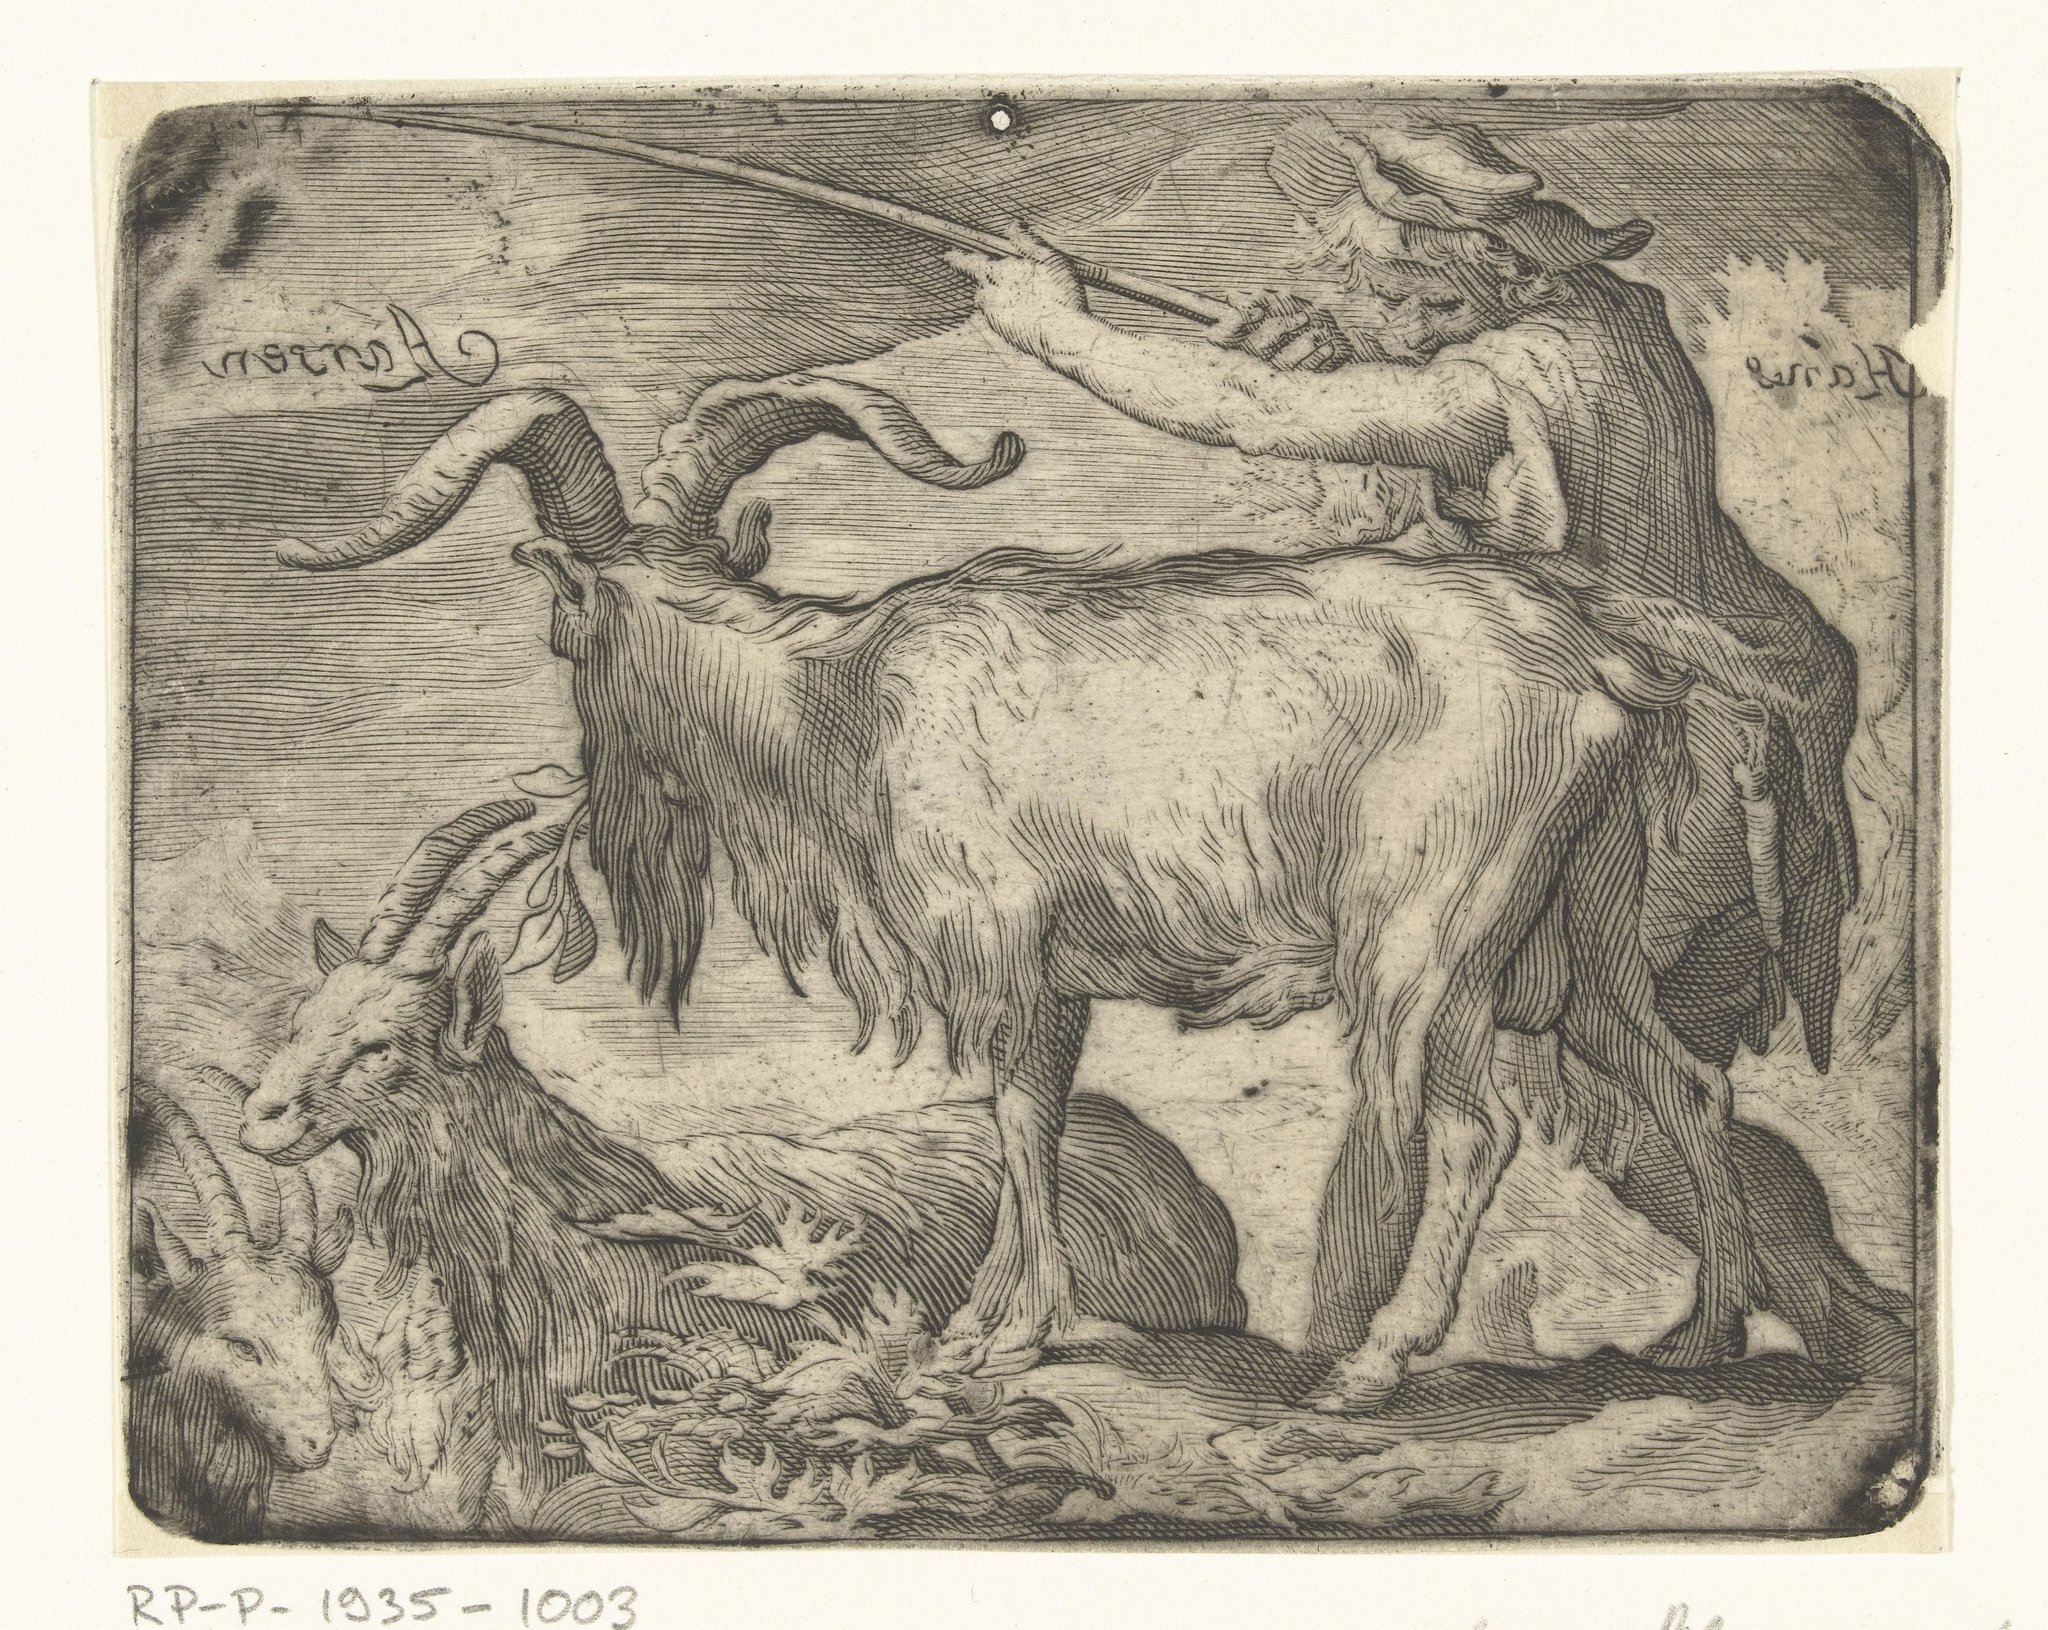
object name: print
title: Jongen met geiten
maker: hans aarsen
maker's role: print maker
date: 1700-1800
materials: paper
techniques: engraving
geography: netherlands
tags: herding, herdsman, herdswoman, shepherd, shepherdess, cowherd, etc., goat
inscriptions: collector's mark: Lugt 2228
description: Jongen met hoed en staf en drie geiten. Op de achtergrond de naam van de prentmaker in spiegelbeeld: Hans Aarsen.